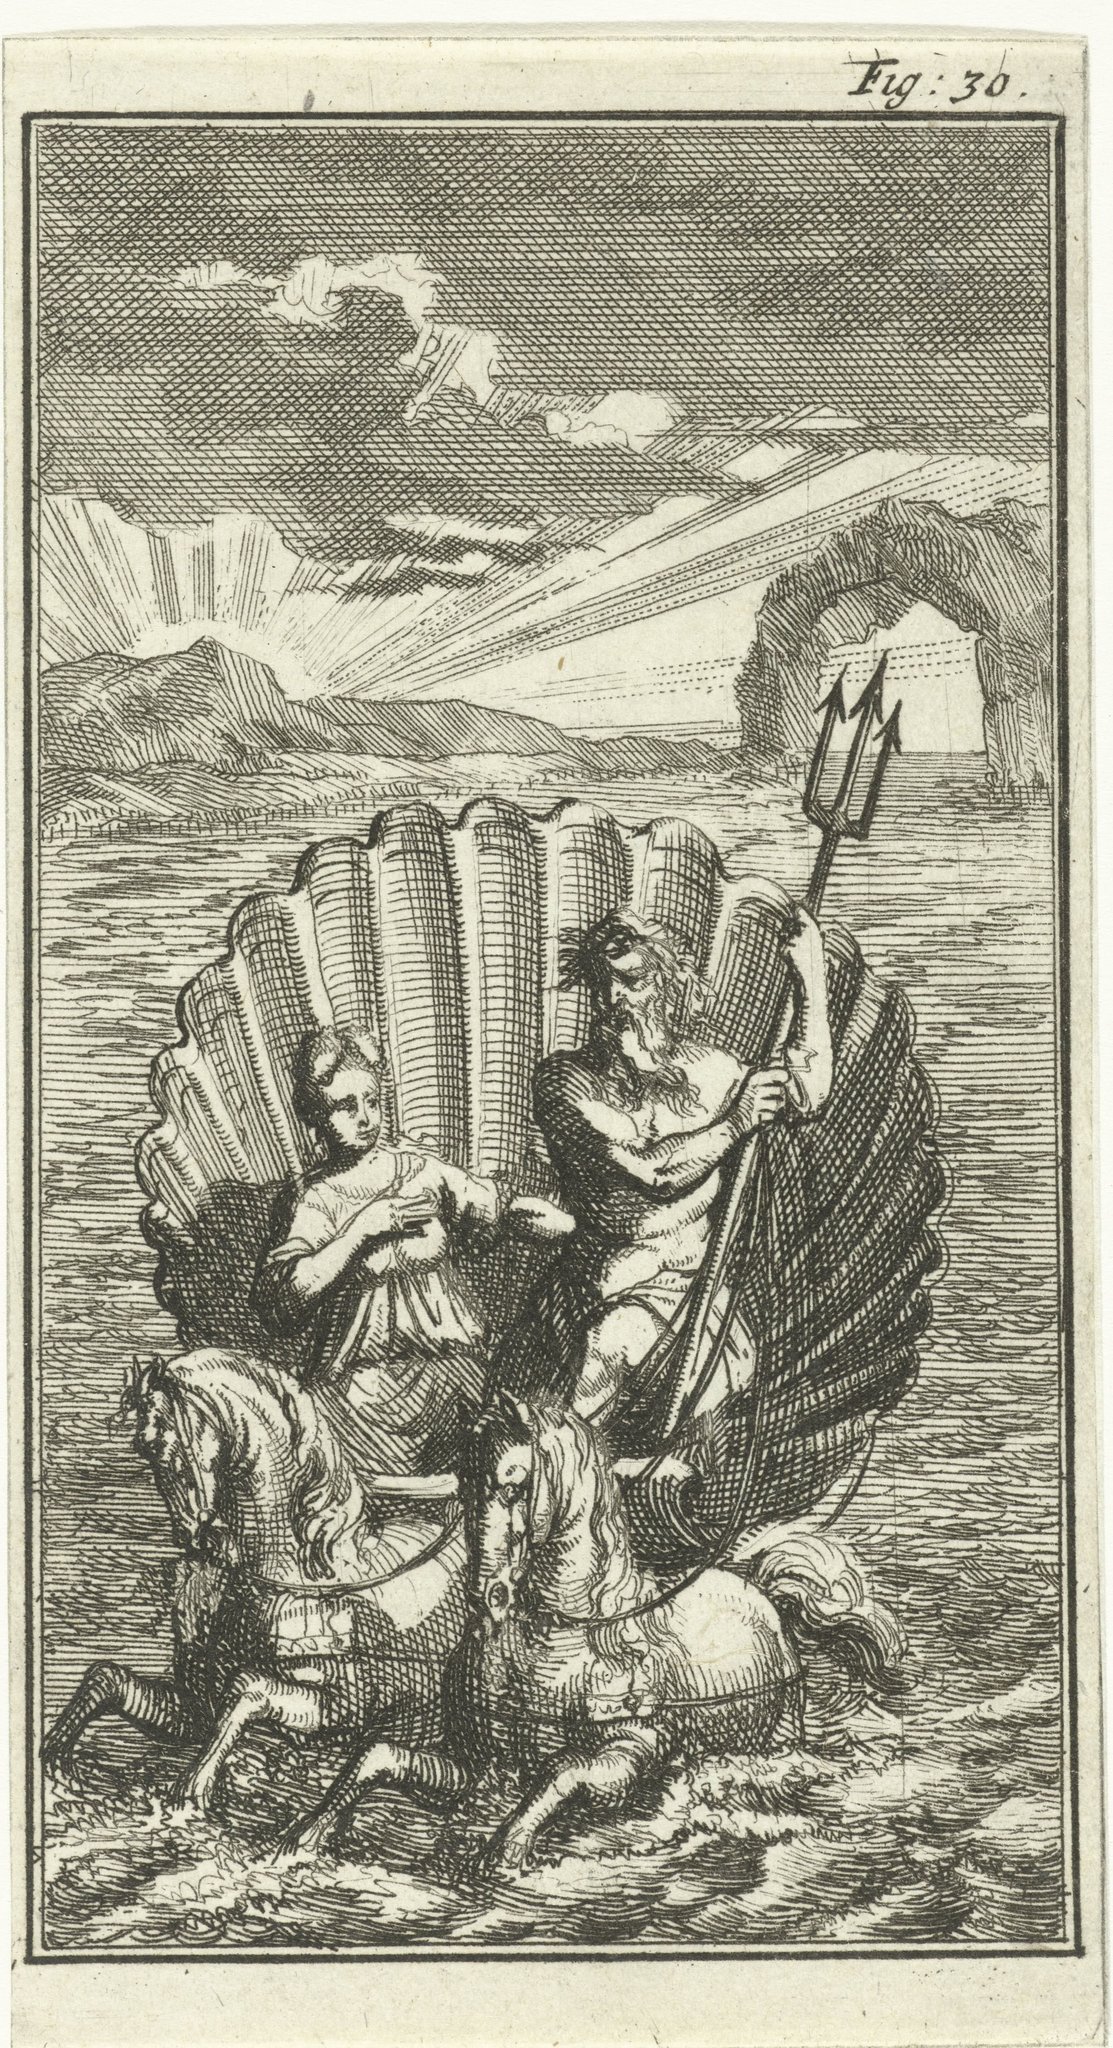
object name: book illustration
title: Neptunus en Amphitrite op een schelp voortgetrokken door zeepaarden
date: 1691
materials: paper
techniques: etching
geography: the hague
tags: triumph of neptune and amphitrite, with a retinue of tritons and nereids, i.e. marriage train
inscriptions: collector's mark: Lugt 2228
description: Illustratie uit: Beeck, Barent. Le triomphe royal, où l'on voit dêscrits les arcs de triomphe (...) erigez à la Haye, à l'honneur de Guillaume III. Den Haag, 1691.